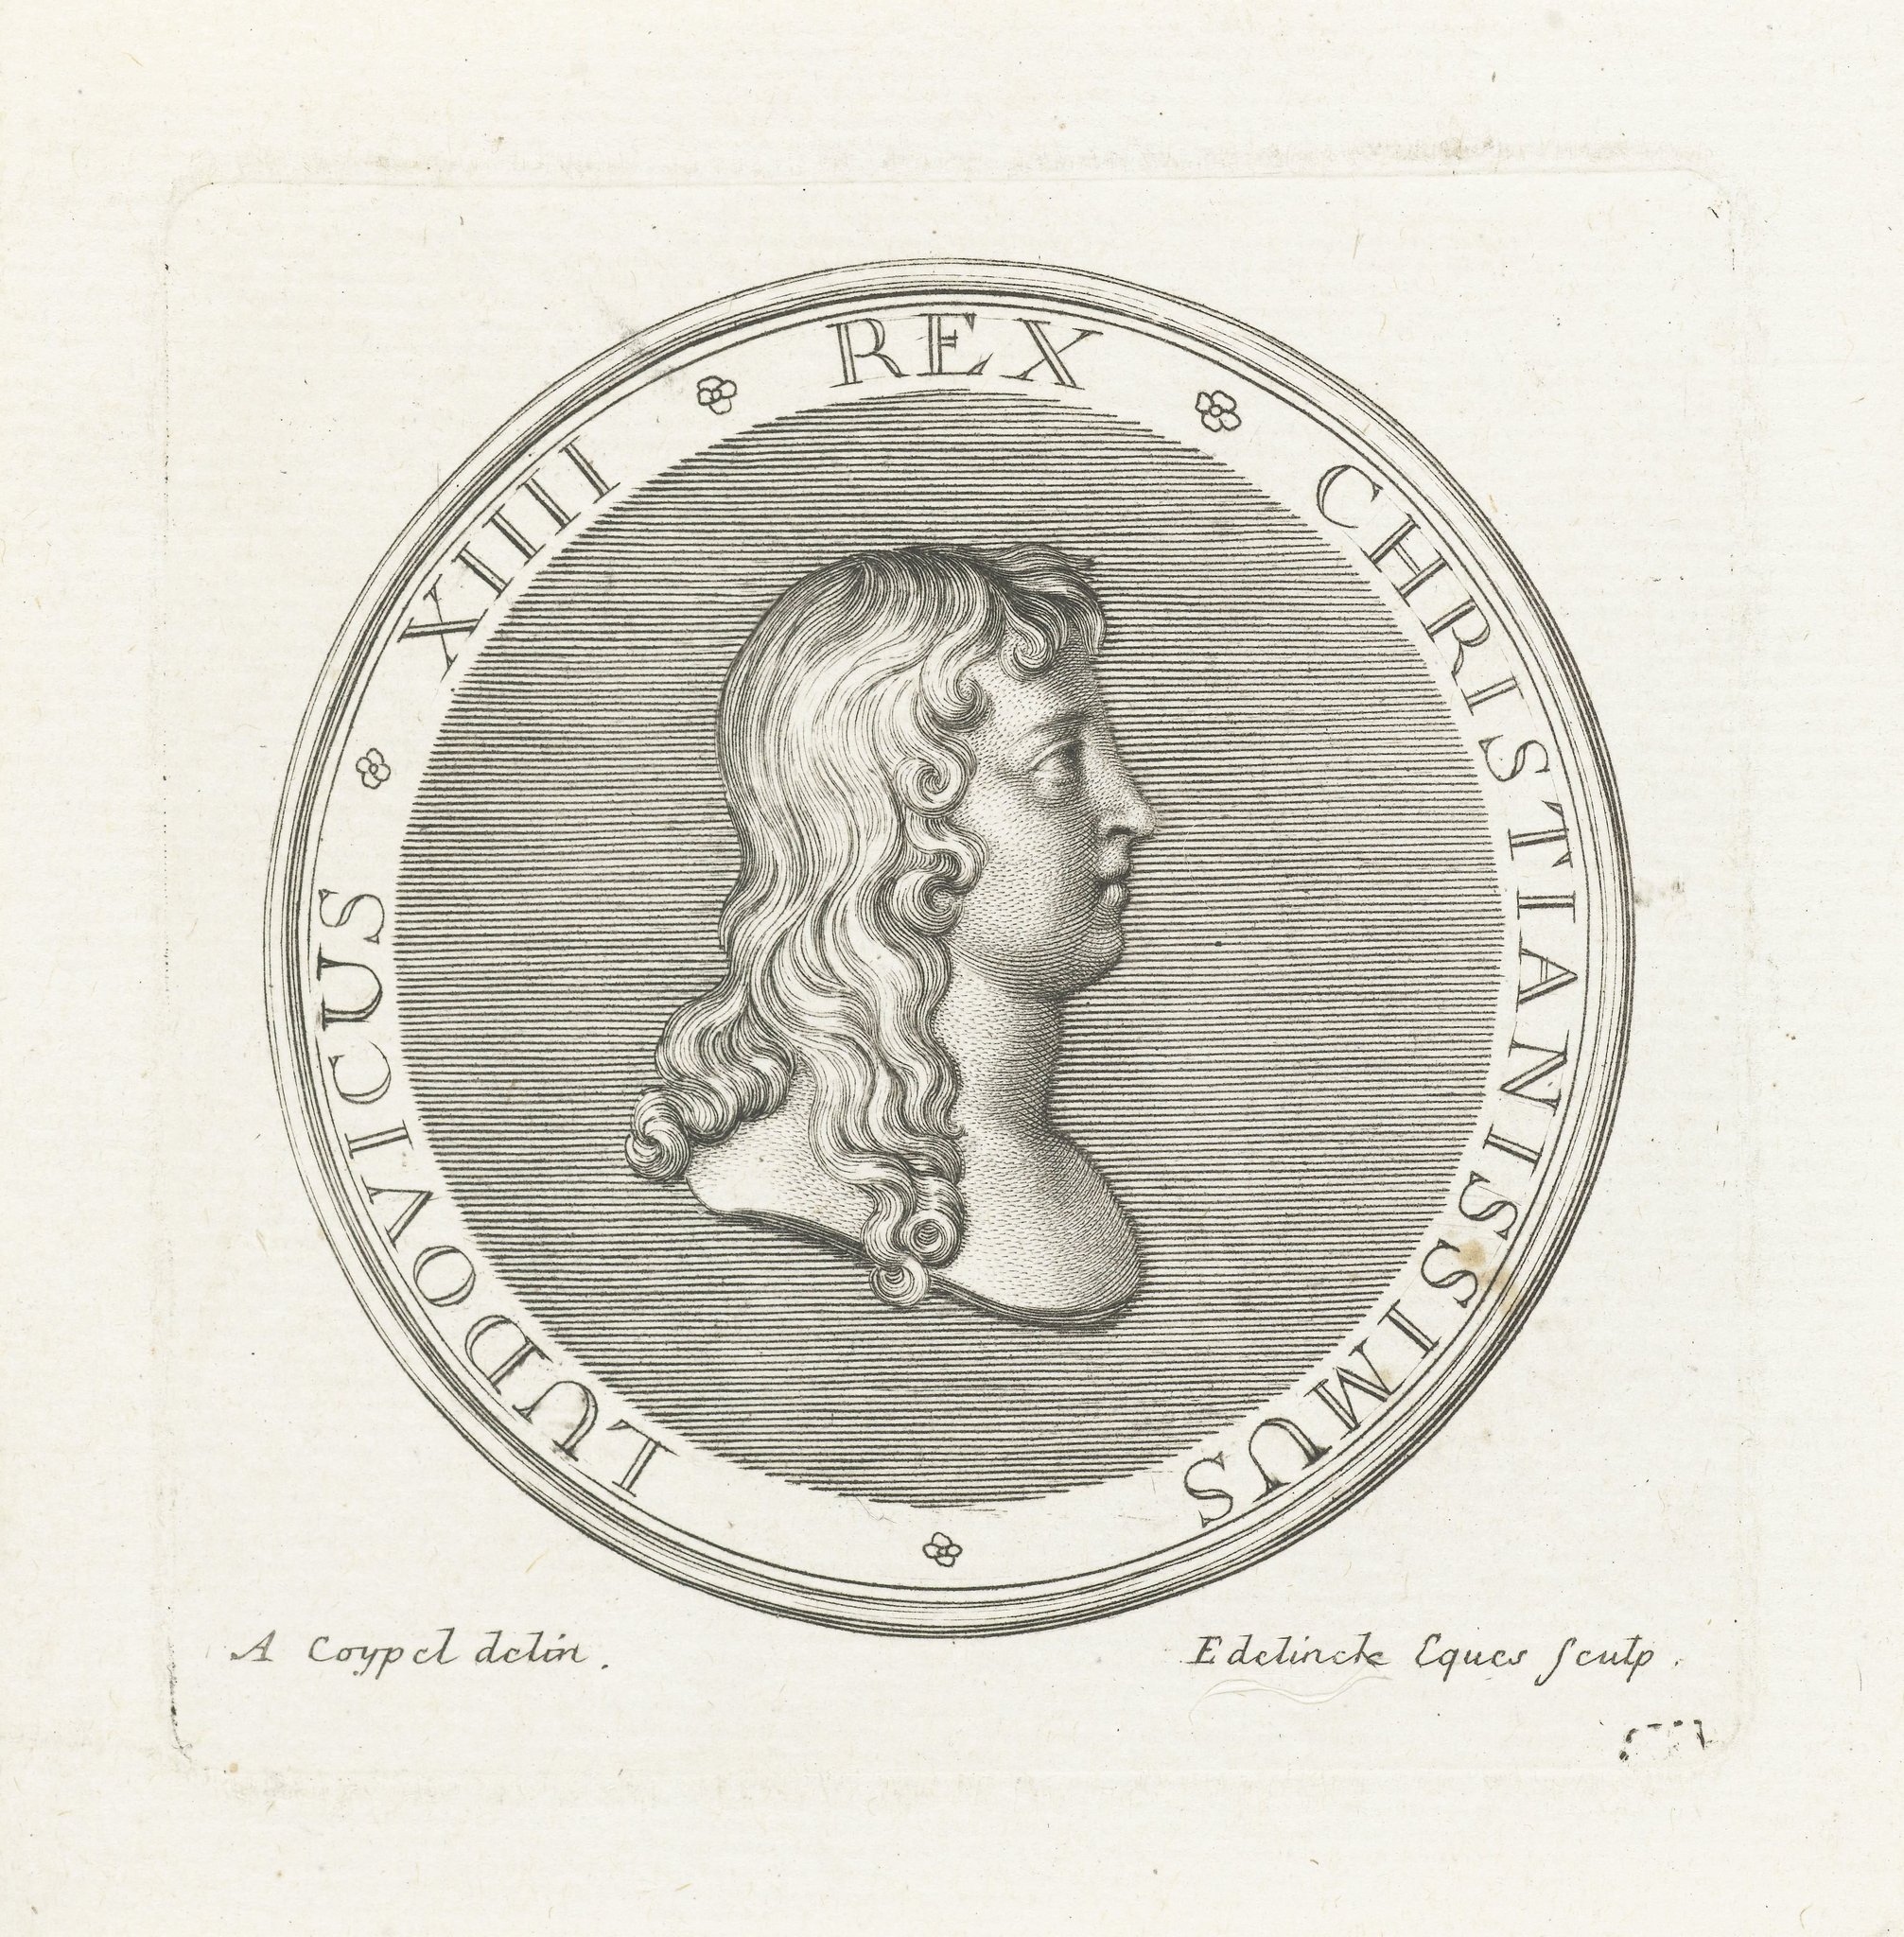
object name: print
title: Penning met buste van Lodewijk XIV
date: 1702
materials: paper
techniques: engraving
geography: paris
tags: lodewijk xiv (koning van frankrijk)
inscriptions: collector's mark: Lugt 240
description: Voorkant van een penning met buste en profil van Lodewijk XIV, voor het eerst uitgegeven na de Slag bij Rocroi in 1643.